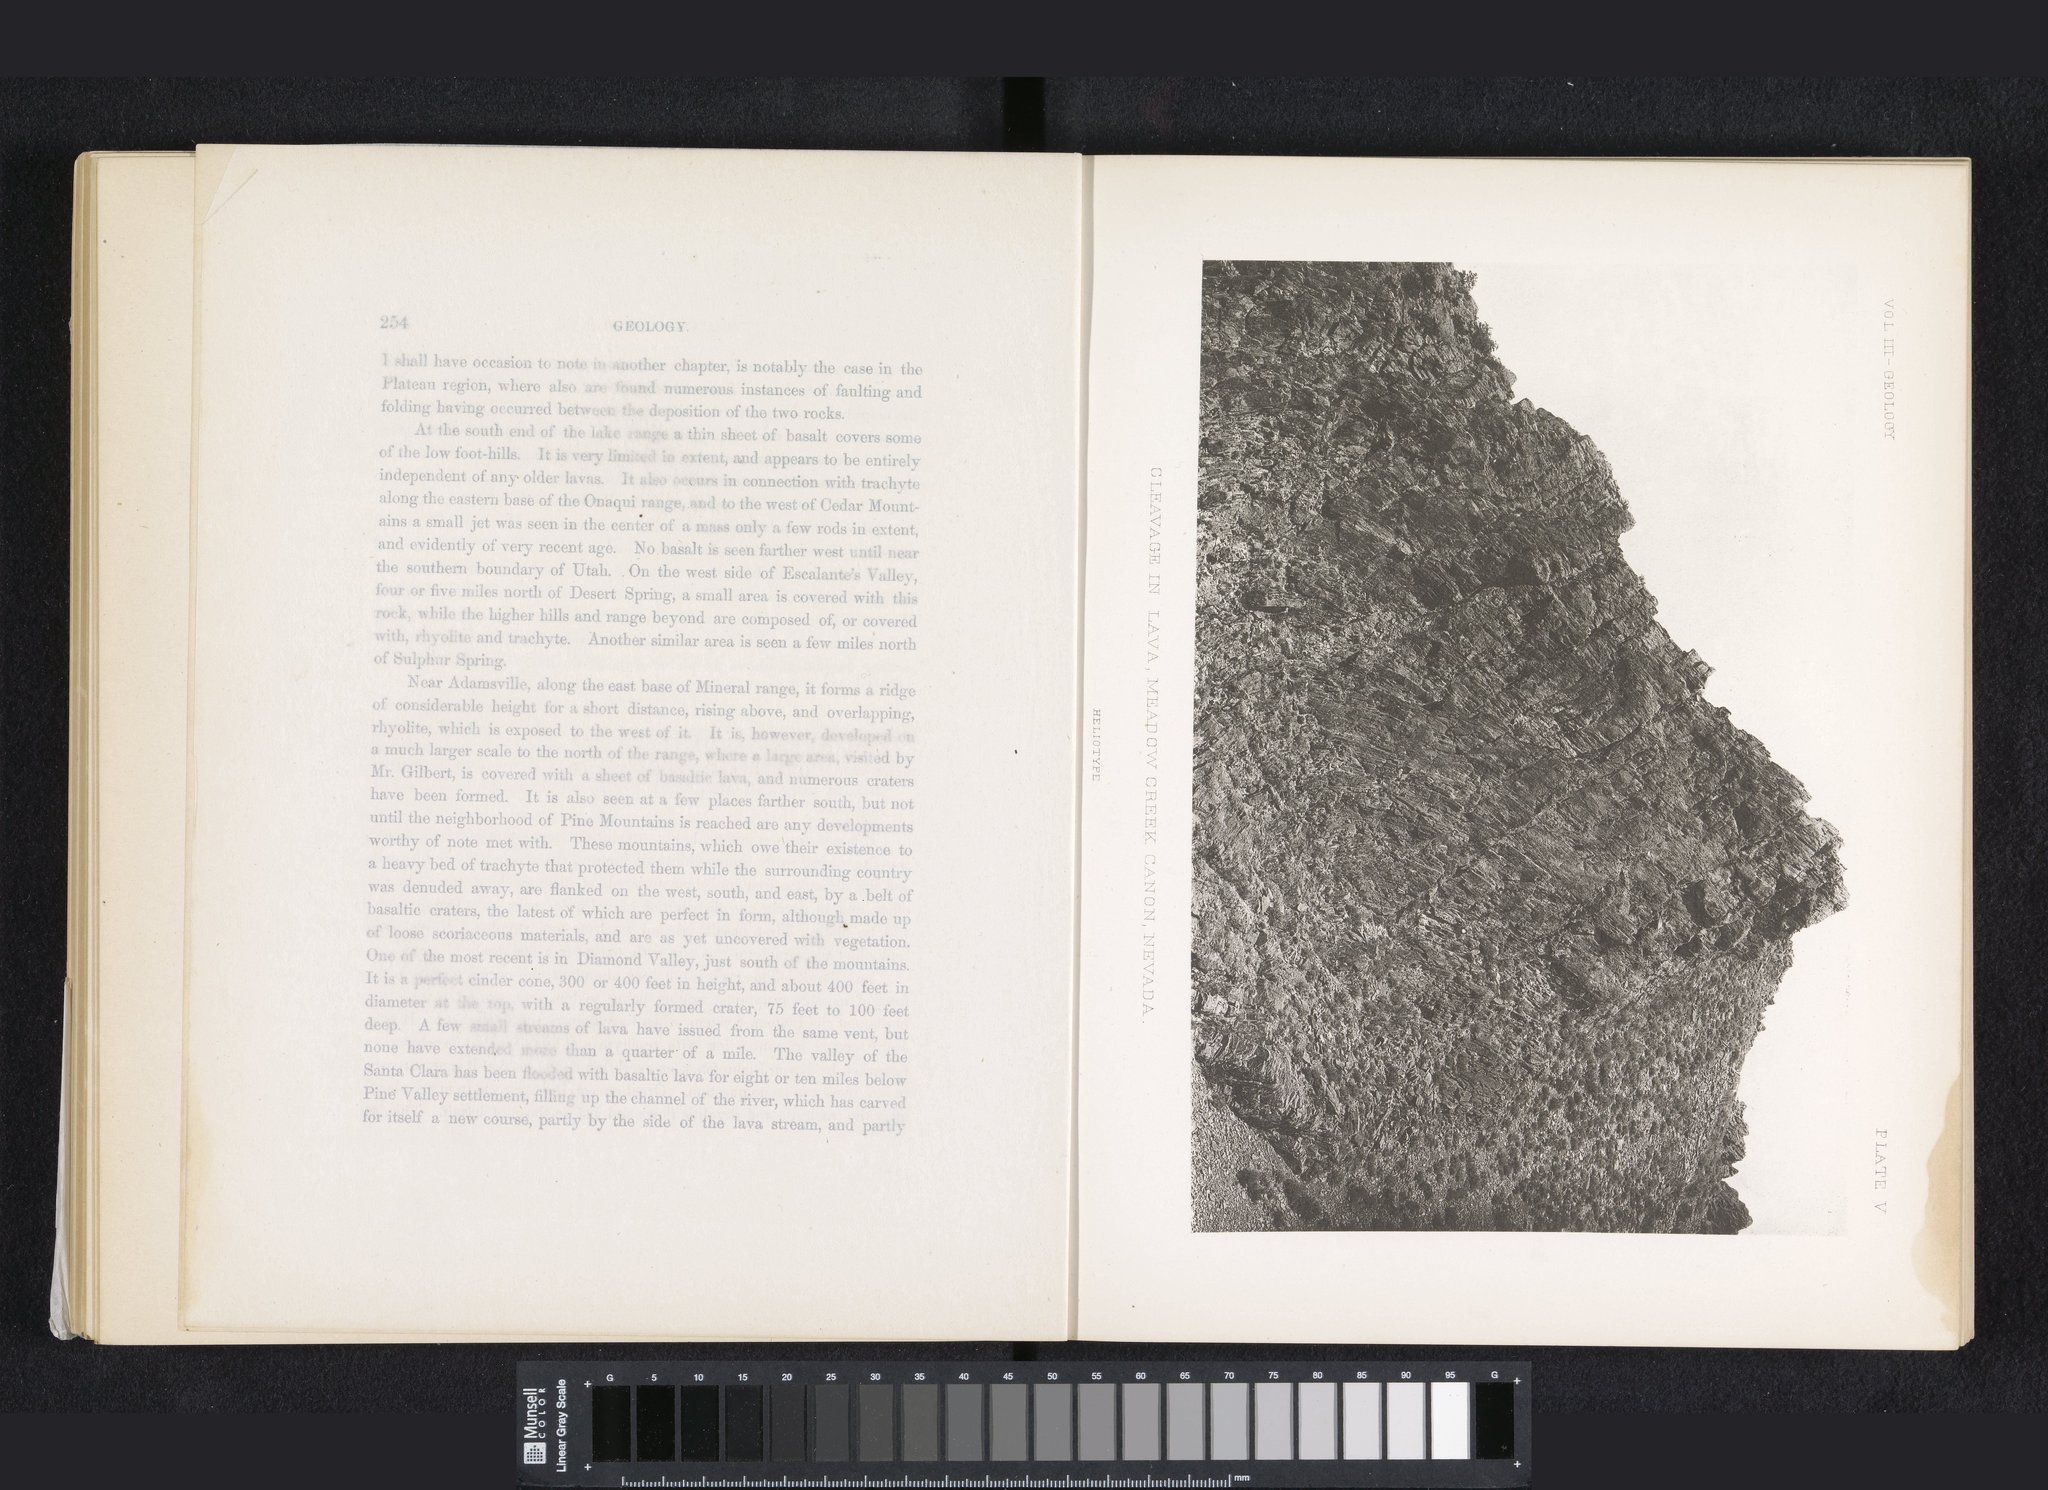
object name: photomechanical print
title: Cleavage in lava, Meadow creek canon, Nevada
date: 1871-1875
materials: paper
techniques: photograph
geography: nevada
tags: cold lava, ravine, chasm, abyss, canyon, mountains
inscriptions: number: ‘Plate V’